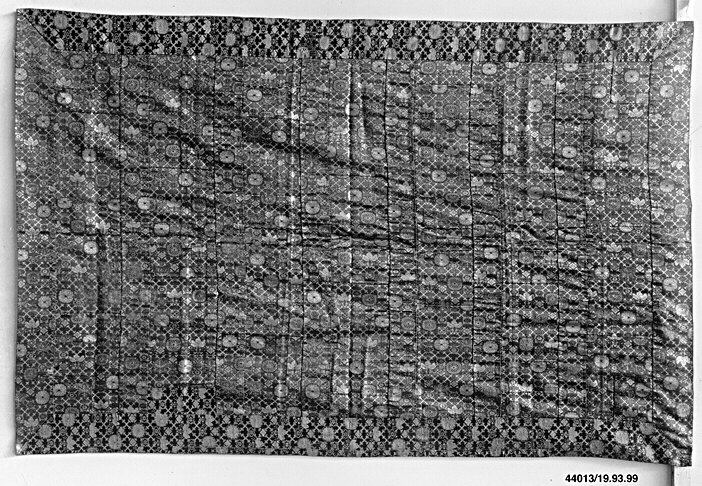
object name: robe, priest's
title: Priest's Robe (Shichijō)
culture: japanese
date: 1648-1652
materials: metal thread, silk